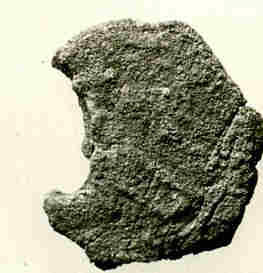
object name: coin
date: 1201-1400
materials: copper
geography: iran